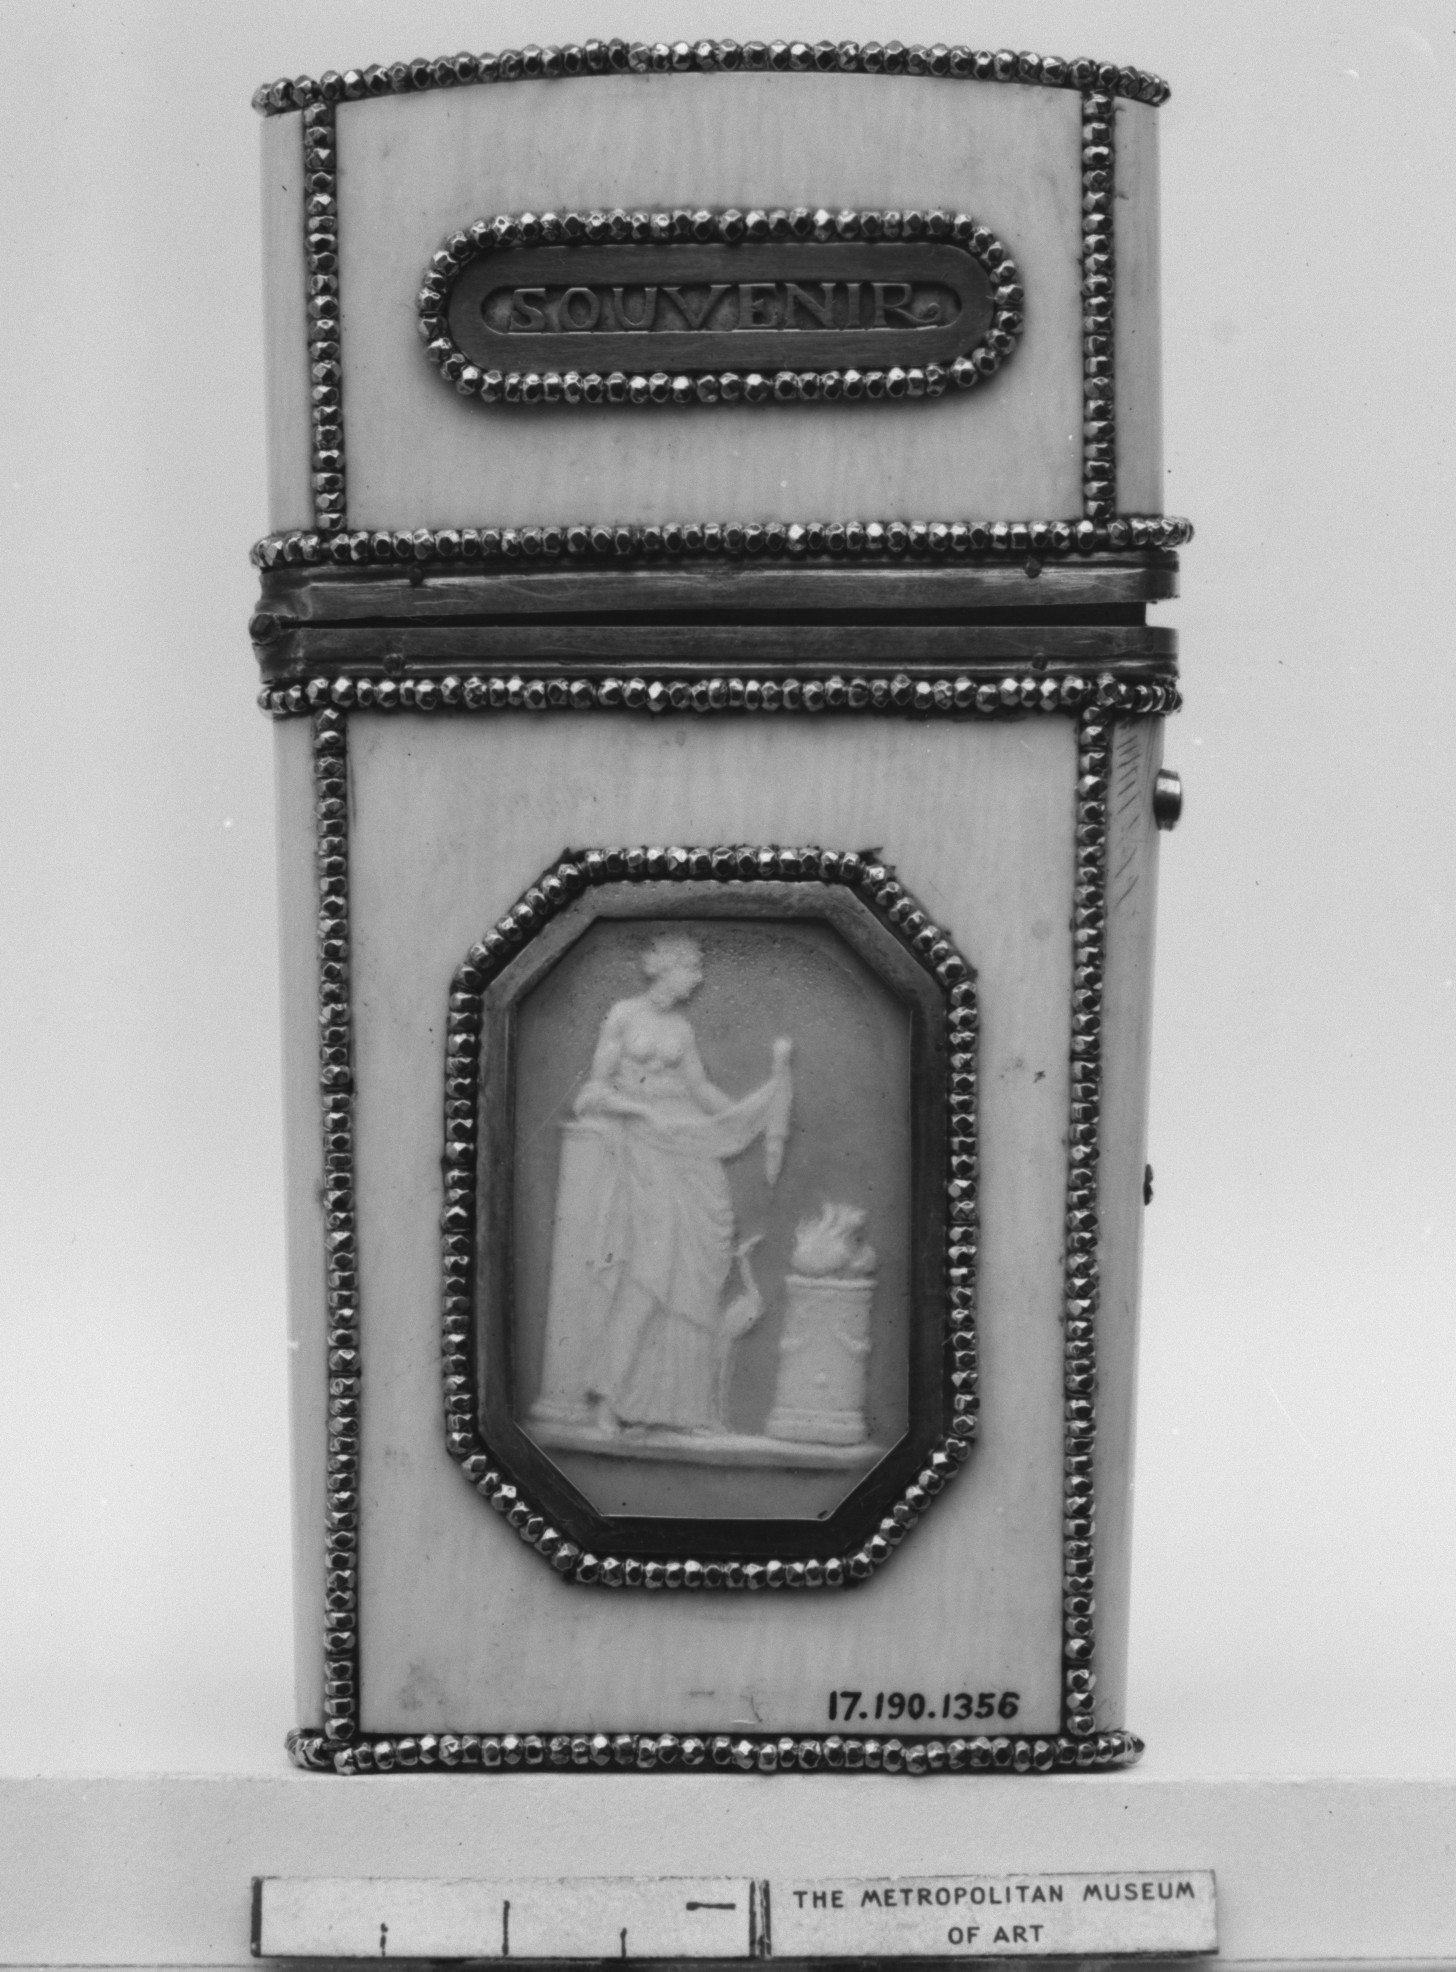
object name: souvenir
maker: sèvres manufactory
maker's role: manufactory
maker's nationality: french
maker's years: 1740-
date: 1780-1790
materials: gold, ivory, porcelain, steel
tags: human figures